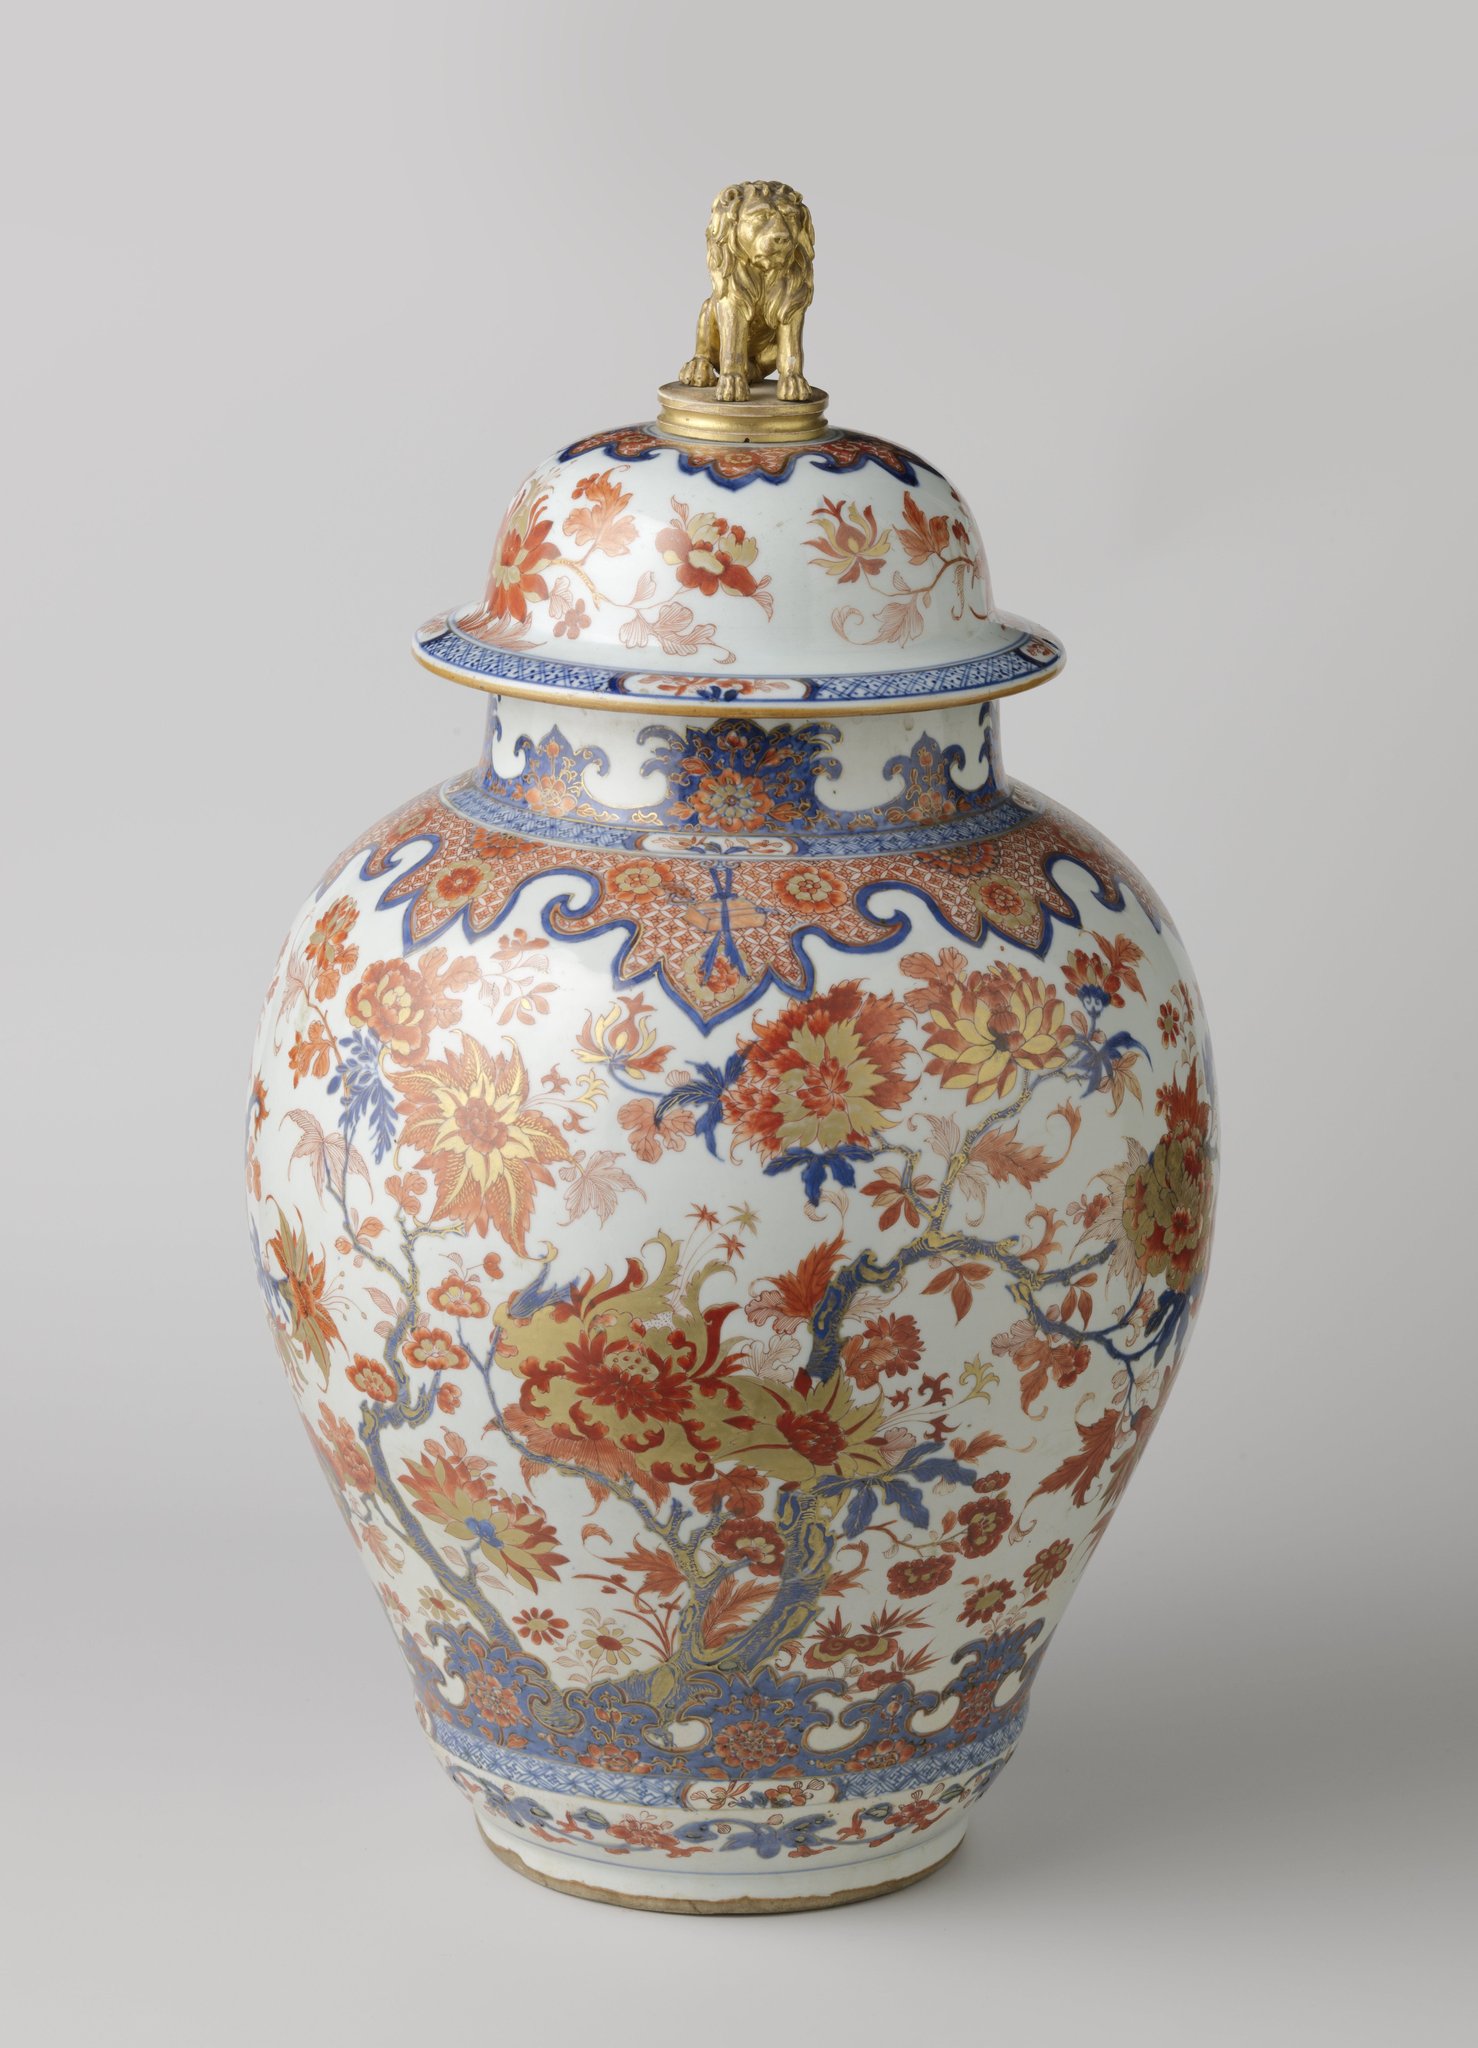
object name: lid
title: Covered baluster jar with large flower sprays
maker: Anonymous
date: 1720-1740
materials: cobalt, glaze, gold, paint, porcelain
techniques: firing, gilding, turning, vitrification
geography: japan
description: Dekselknop van balustervormige dekselpot van porselein in de vorm van een leeuw, beschilderd in onderglazuur blauw en op het glazuur rood en goud. Beschilderd met twee grote, bloeiende lotusplanten; om de rand servetwerk afgewisseld met bloemtakken in cartouches. Imari.